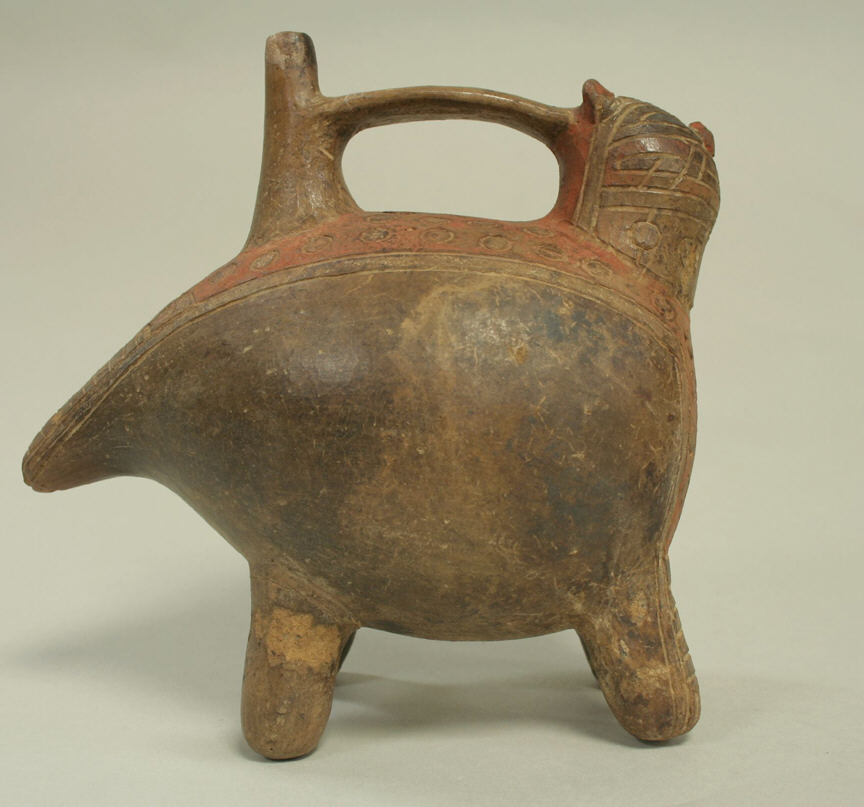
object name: bottle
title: Double Spout and Bridge Bottle in Feline Shape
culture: paracas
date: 500-201 BCE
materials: ceramic, pigment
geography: peru